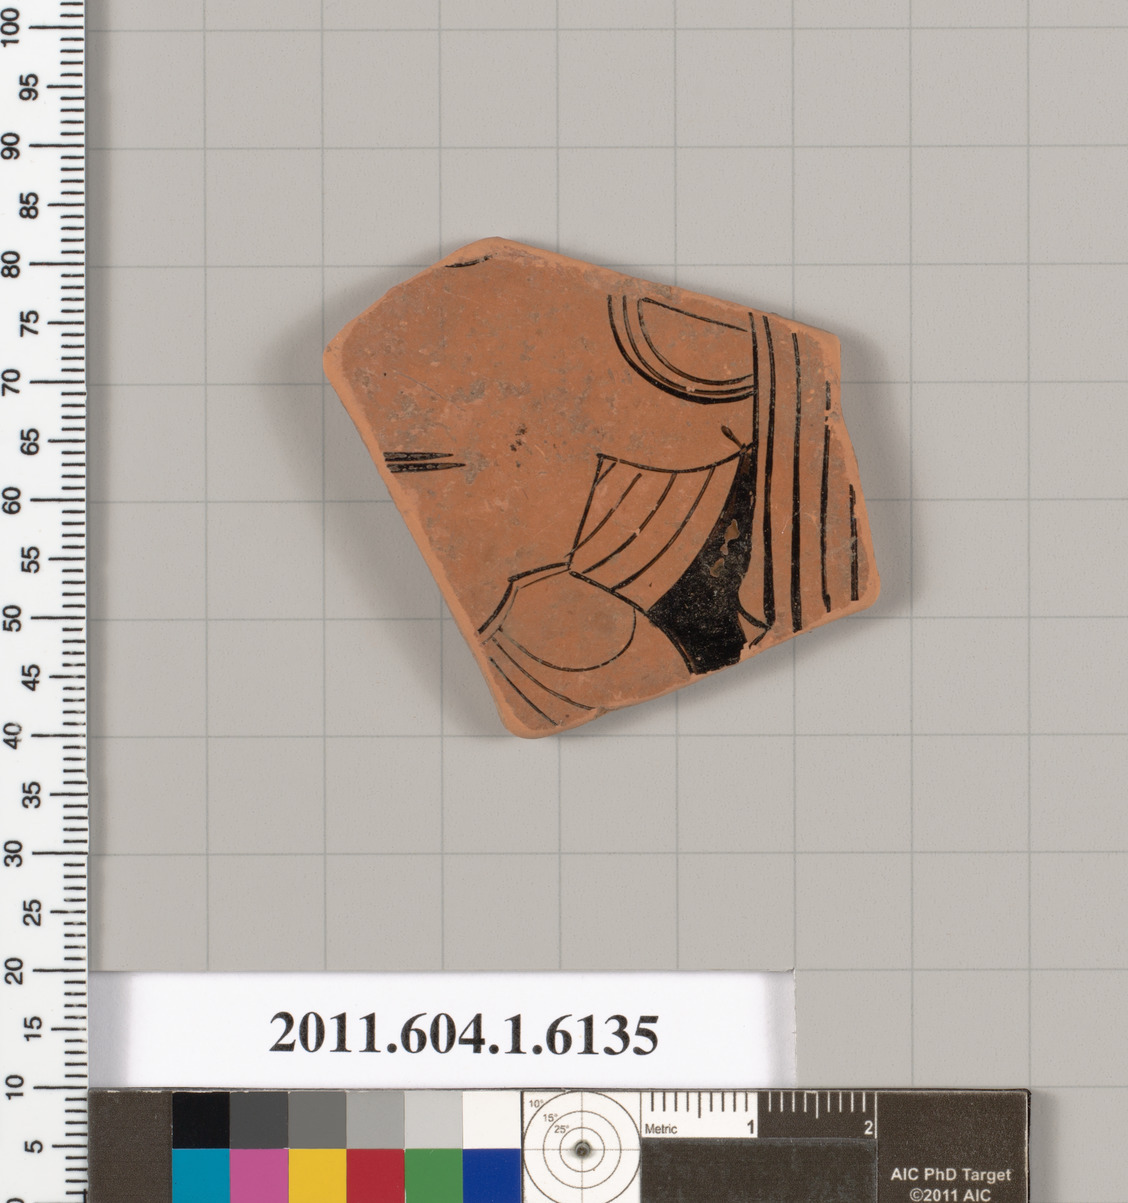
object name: kylix fragment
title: Terracotta fragment of a kylix (drinking cup)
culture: greek, attic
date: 520-500 BCE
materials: terracotta